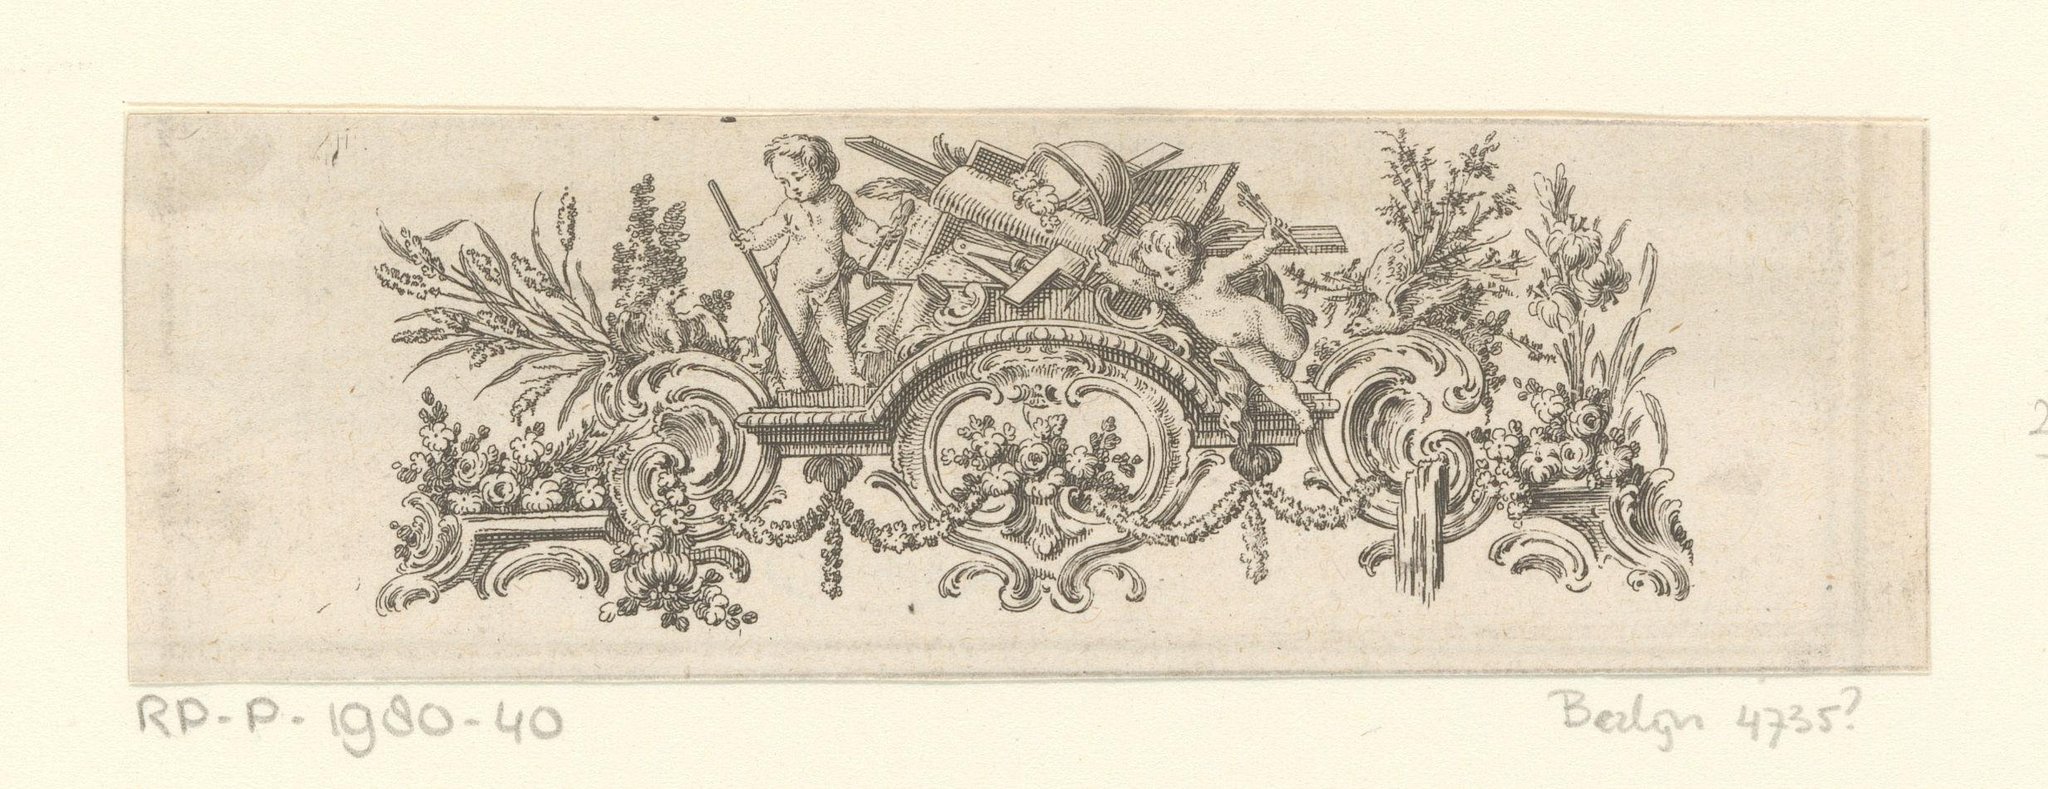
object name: ornament print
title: Vignet met putti met meetkundige objecten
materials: paper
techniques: etching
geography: paris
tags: measuring-instruments, ornament ~ cartouche, cupids: 'amores', 'amoretti', 'putti'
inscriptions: collector's mark: Lugt 2228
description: Pagina 220 uit: Edme-Sébastien. Traité de perspective à l'usage des artistes (...). Parijs: Jombert, Charles Antoine, 1750.